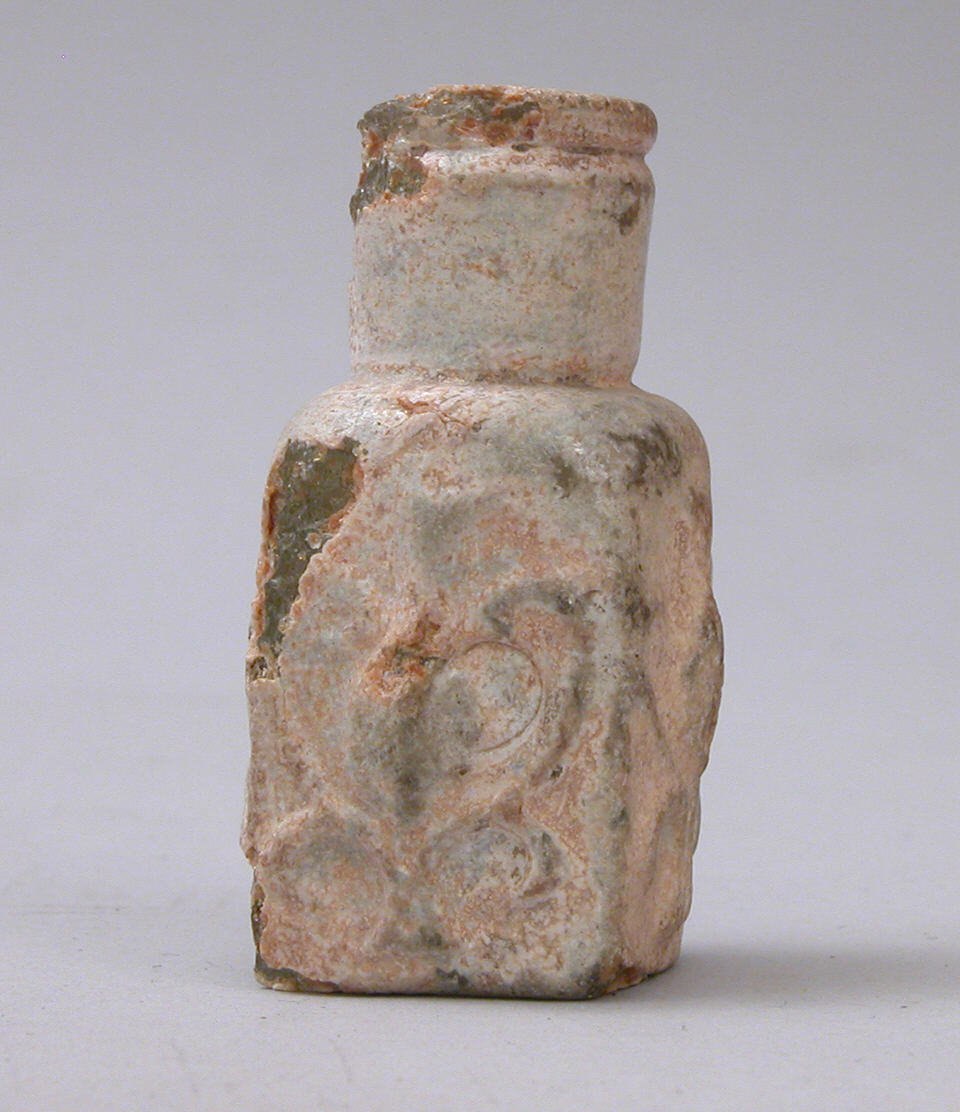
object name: bottle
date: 601-800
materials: glass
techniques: glassblowing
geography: iraq